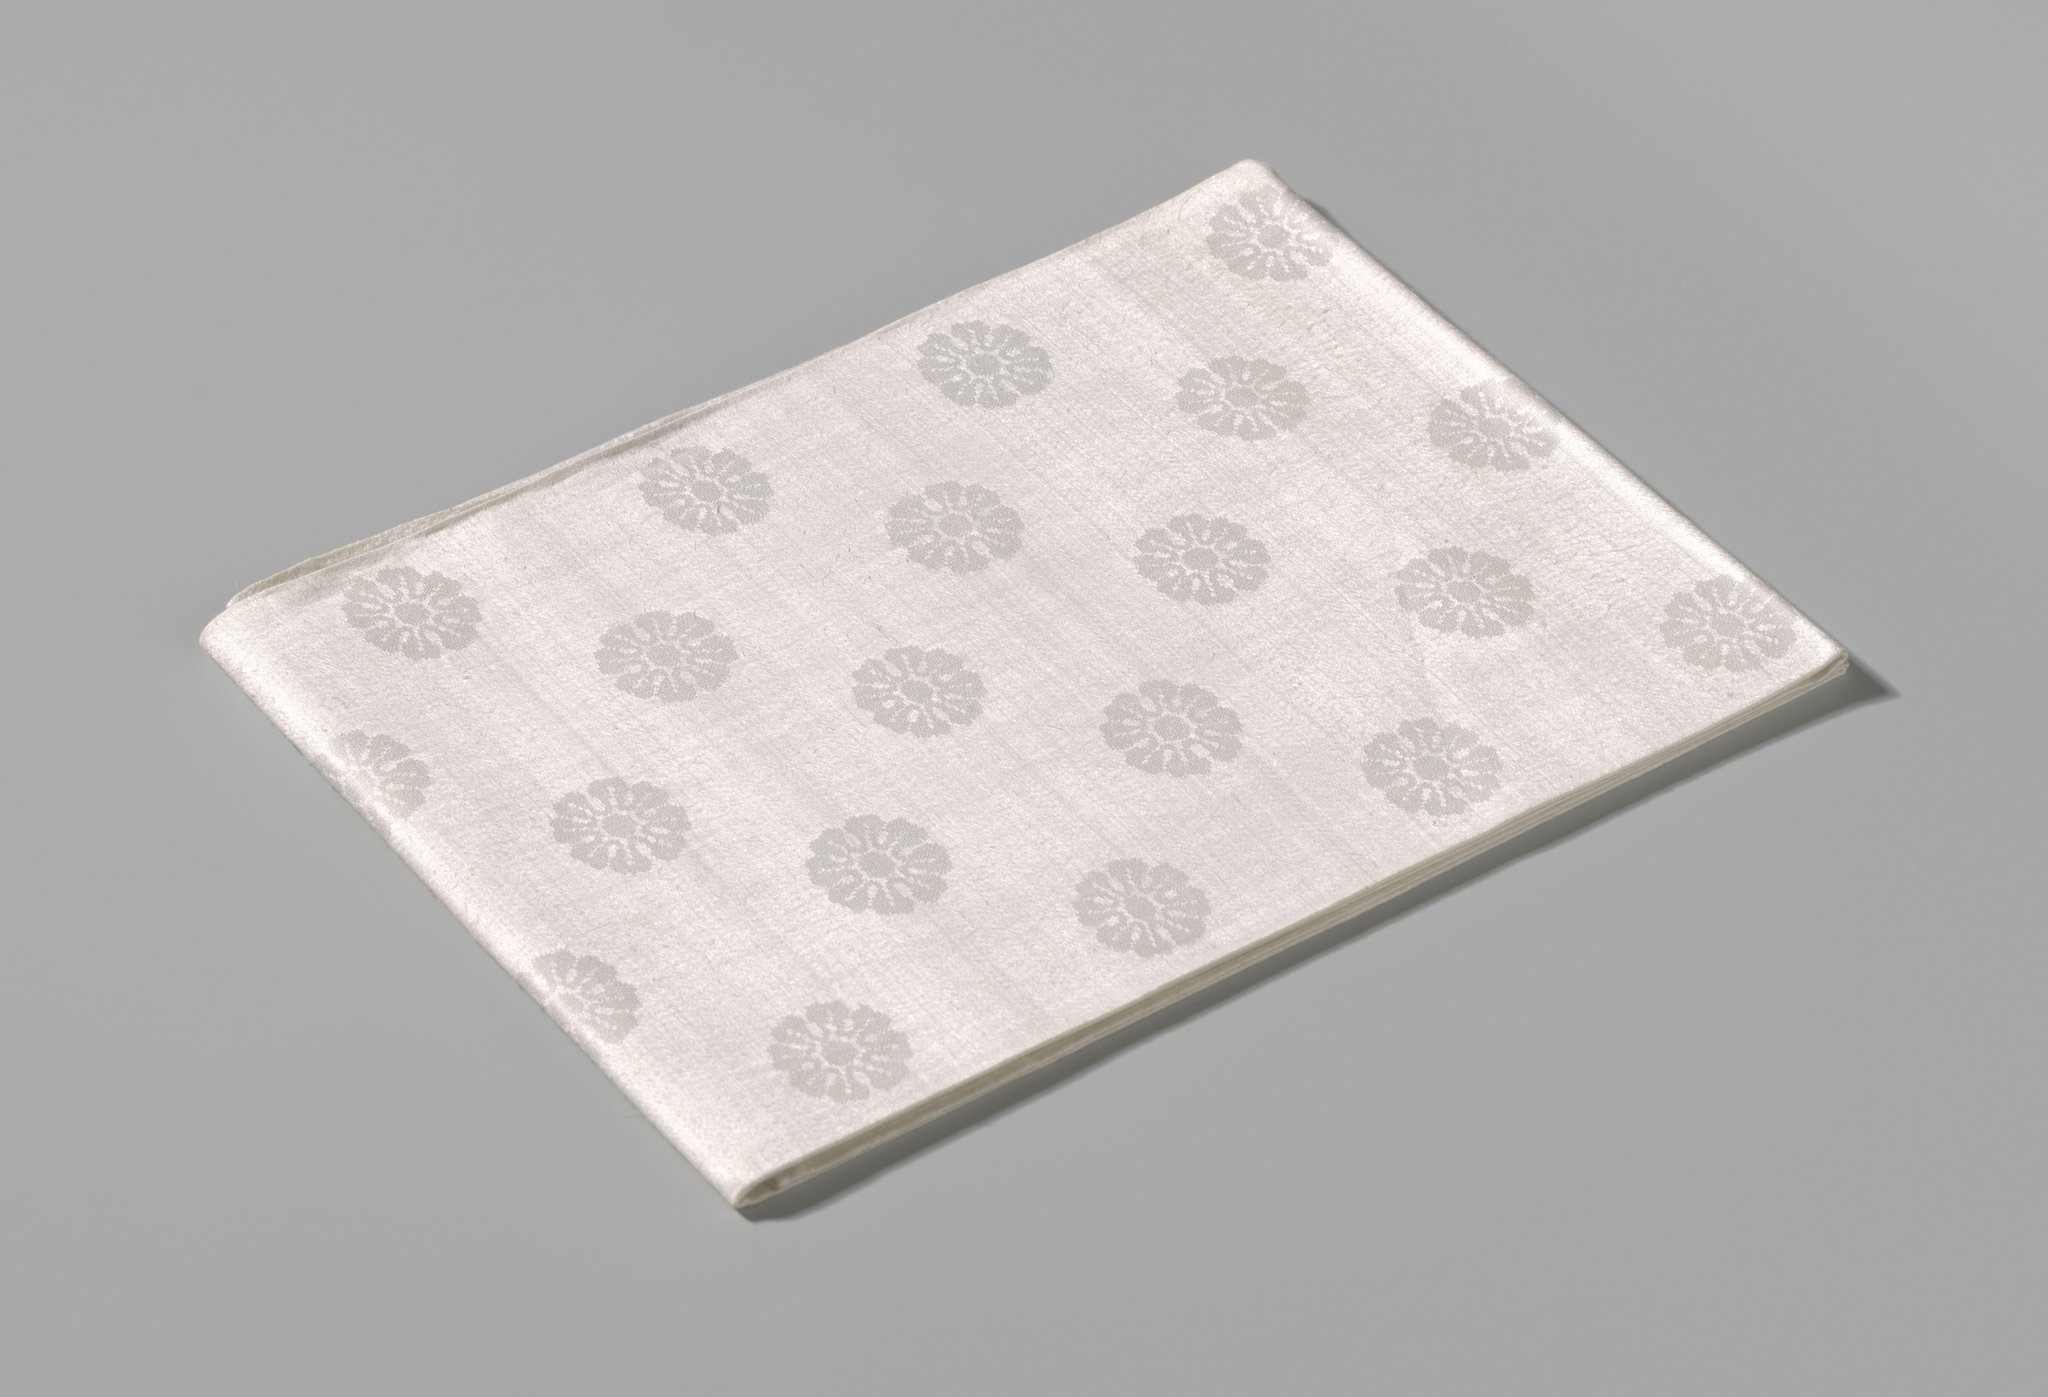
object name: napkin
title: Servet van linnendamast met een bloempatroon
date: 1849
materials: linen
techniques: damask, weave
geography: northern netherlands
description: Servet van linnendamast. Het veld heeft verspringende rijen rozetten en de randen hebben bloemen en acanthusbladeren. De hoeken hebben een vaas met vruchten. Het servet is gemerkt: HW36 1849. Het servet hoort bij dertien servetten (BK-1980-377-A t/m BK-1980-377-N).